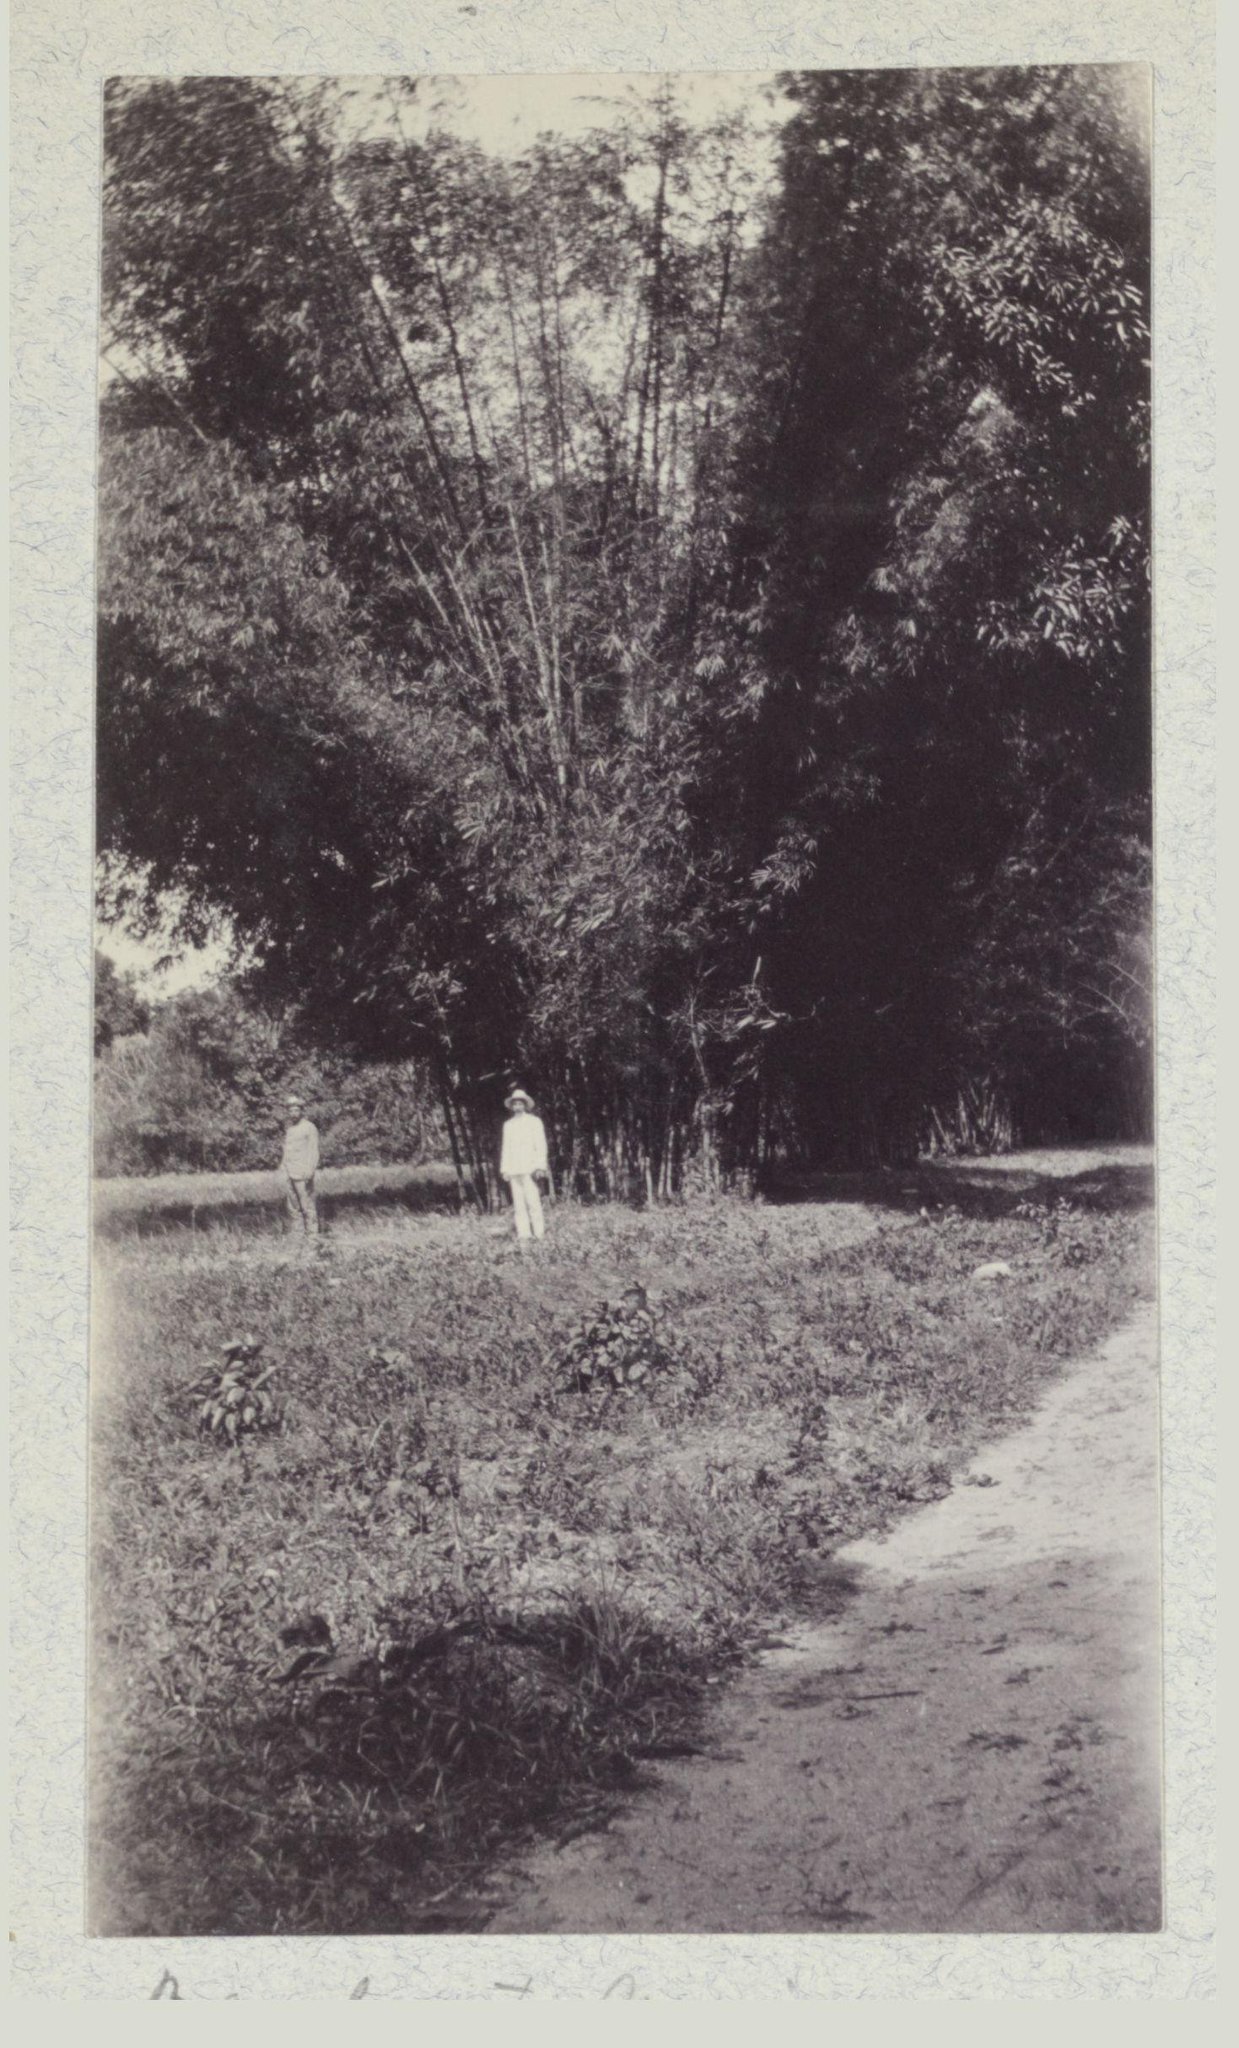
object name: photograph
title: Bamboe te Groningen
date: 1910-1911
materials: photographic support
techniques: photography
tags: suriname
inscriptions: inscription: ‘Bamboe te Groningen / Stephan Gonggrijp. Oct. '11’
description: Stephan Gonggrijp poserend voor een hoge bamboestruik te Groningen, oktober 1911. Onderdeel van het fotoalbum van de familie Boom-Gonggrijp in Suriname en Curaçao.